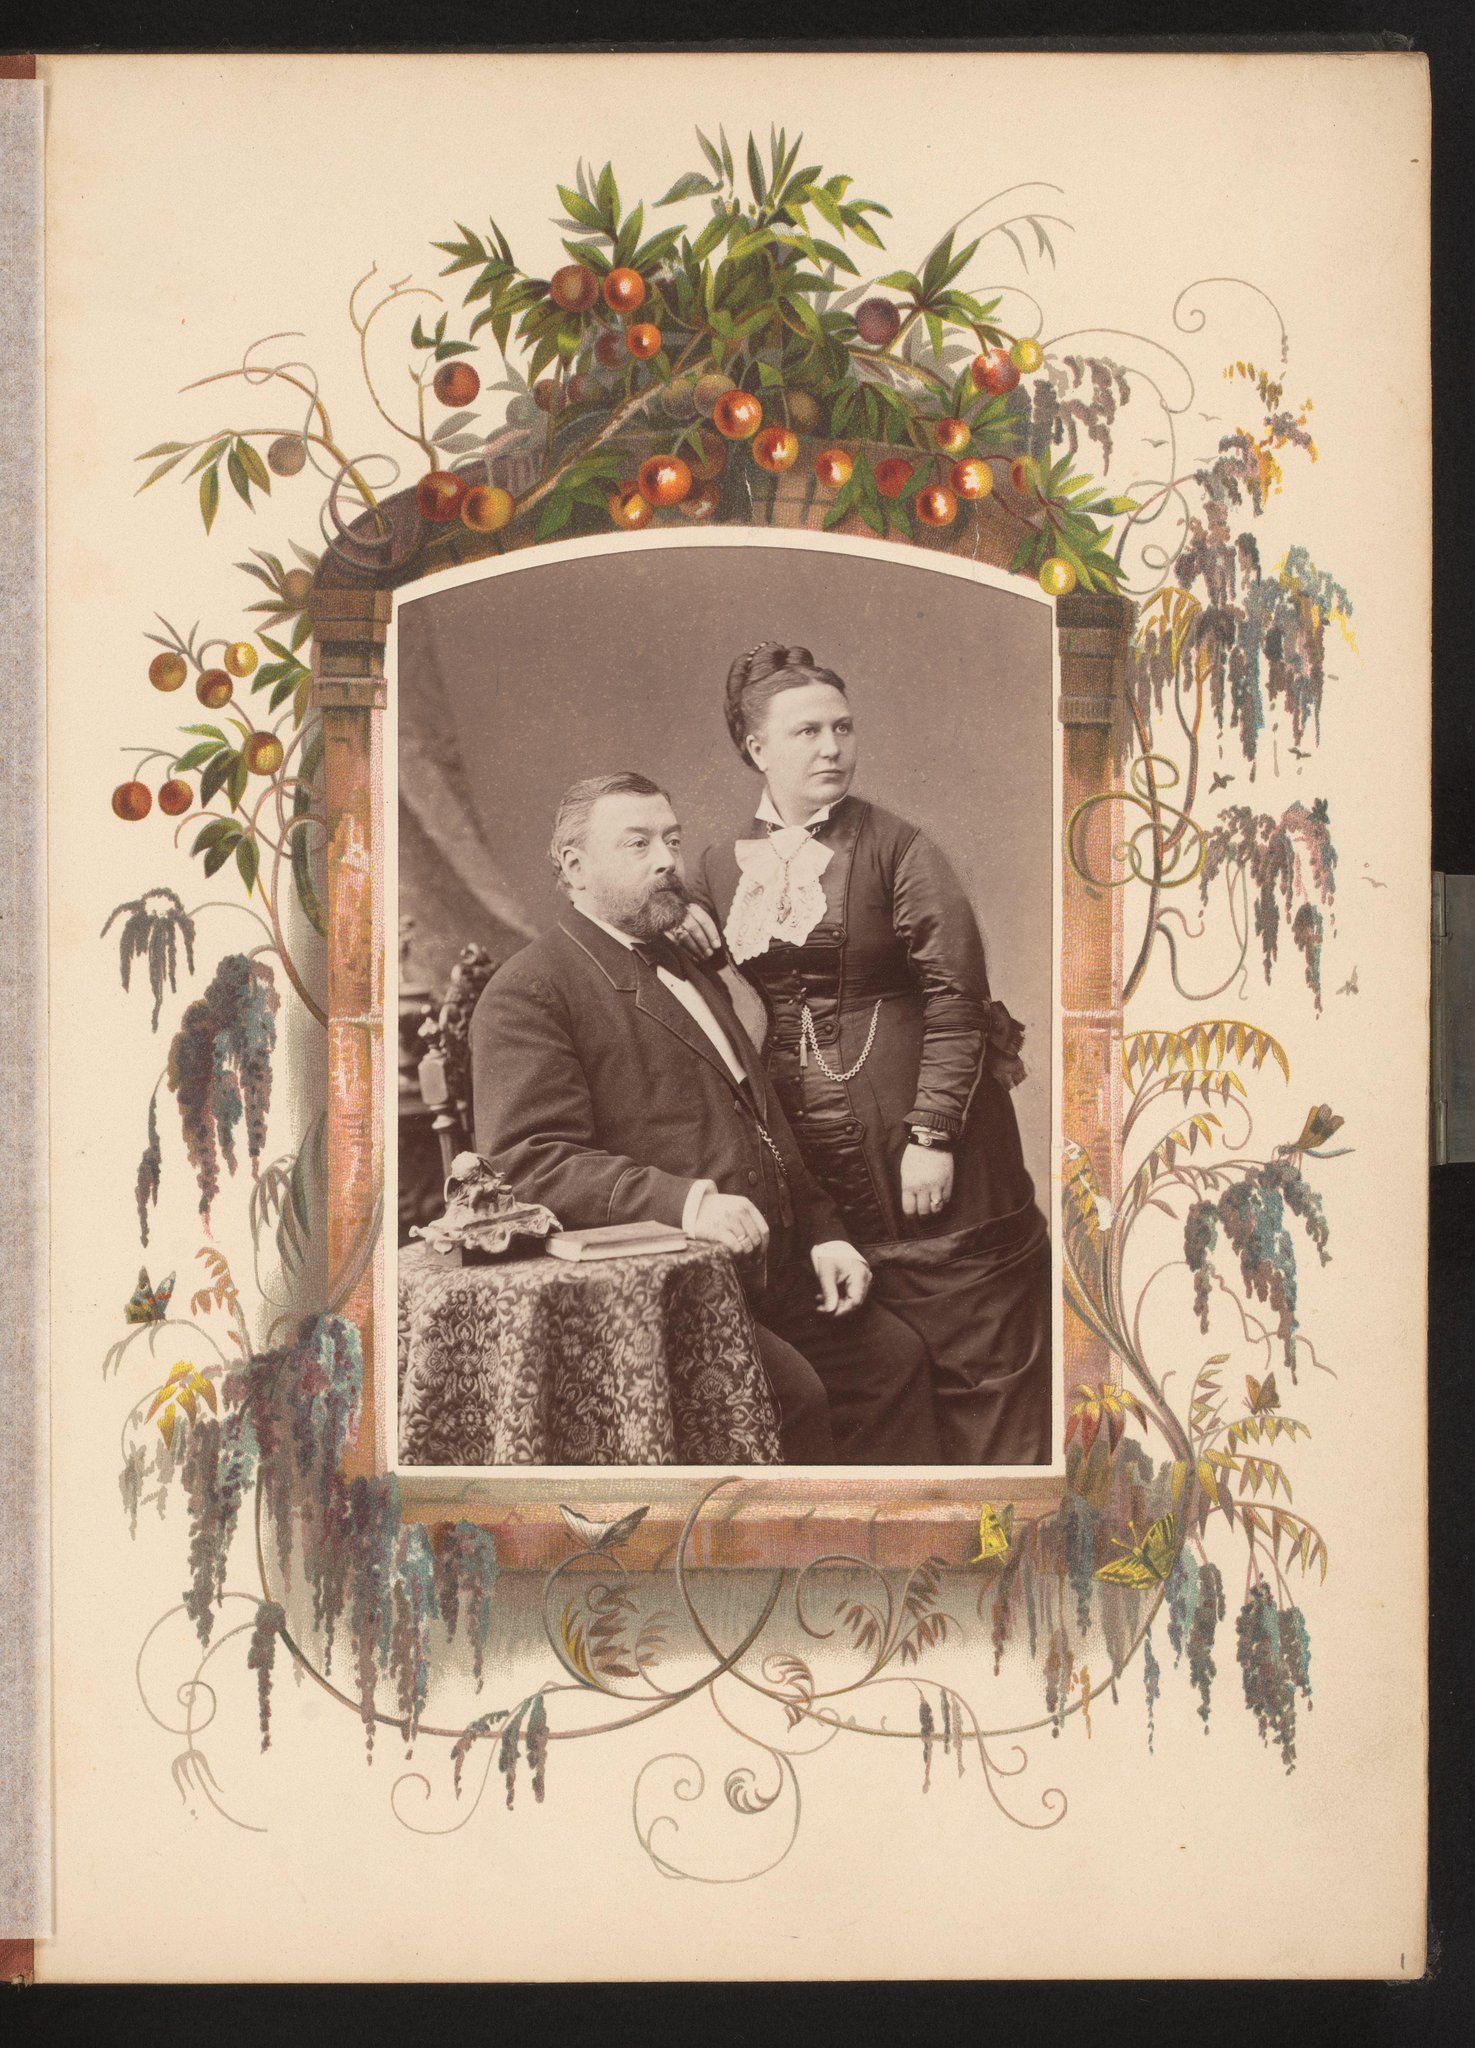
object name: cabinet photograph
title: Portret van een man en een vrouw bij een tafel met een boek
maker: jean baptiste feilner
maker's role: fotograaf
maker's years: 1844-1912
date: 1875-1899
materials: cardboard, photographic support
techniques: albumen print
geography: bremen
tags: historical persons - bb - woman, historical persons, table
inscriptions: inscription: ‘Jean Baptiste Feilner/ Photograph/ Bremen, Wall 185/ schräg gegenüber dem Stadttheater.’